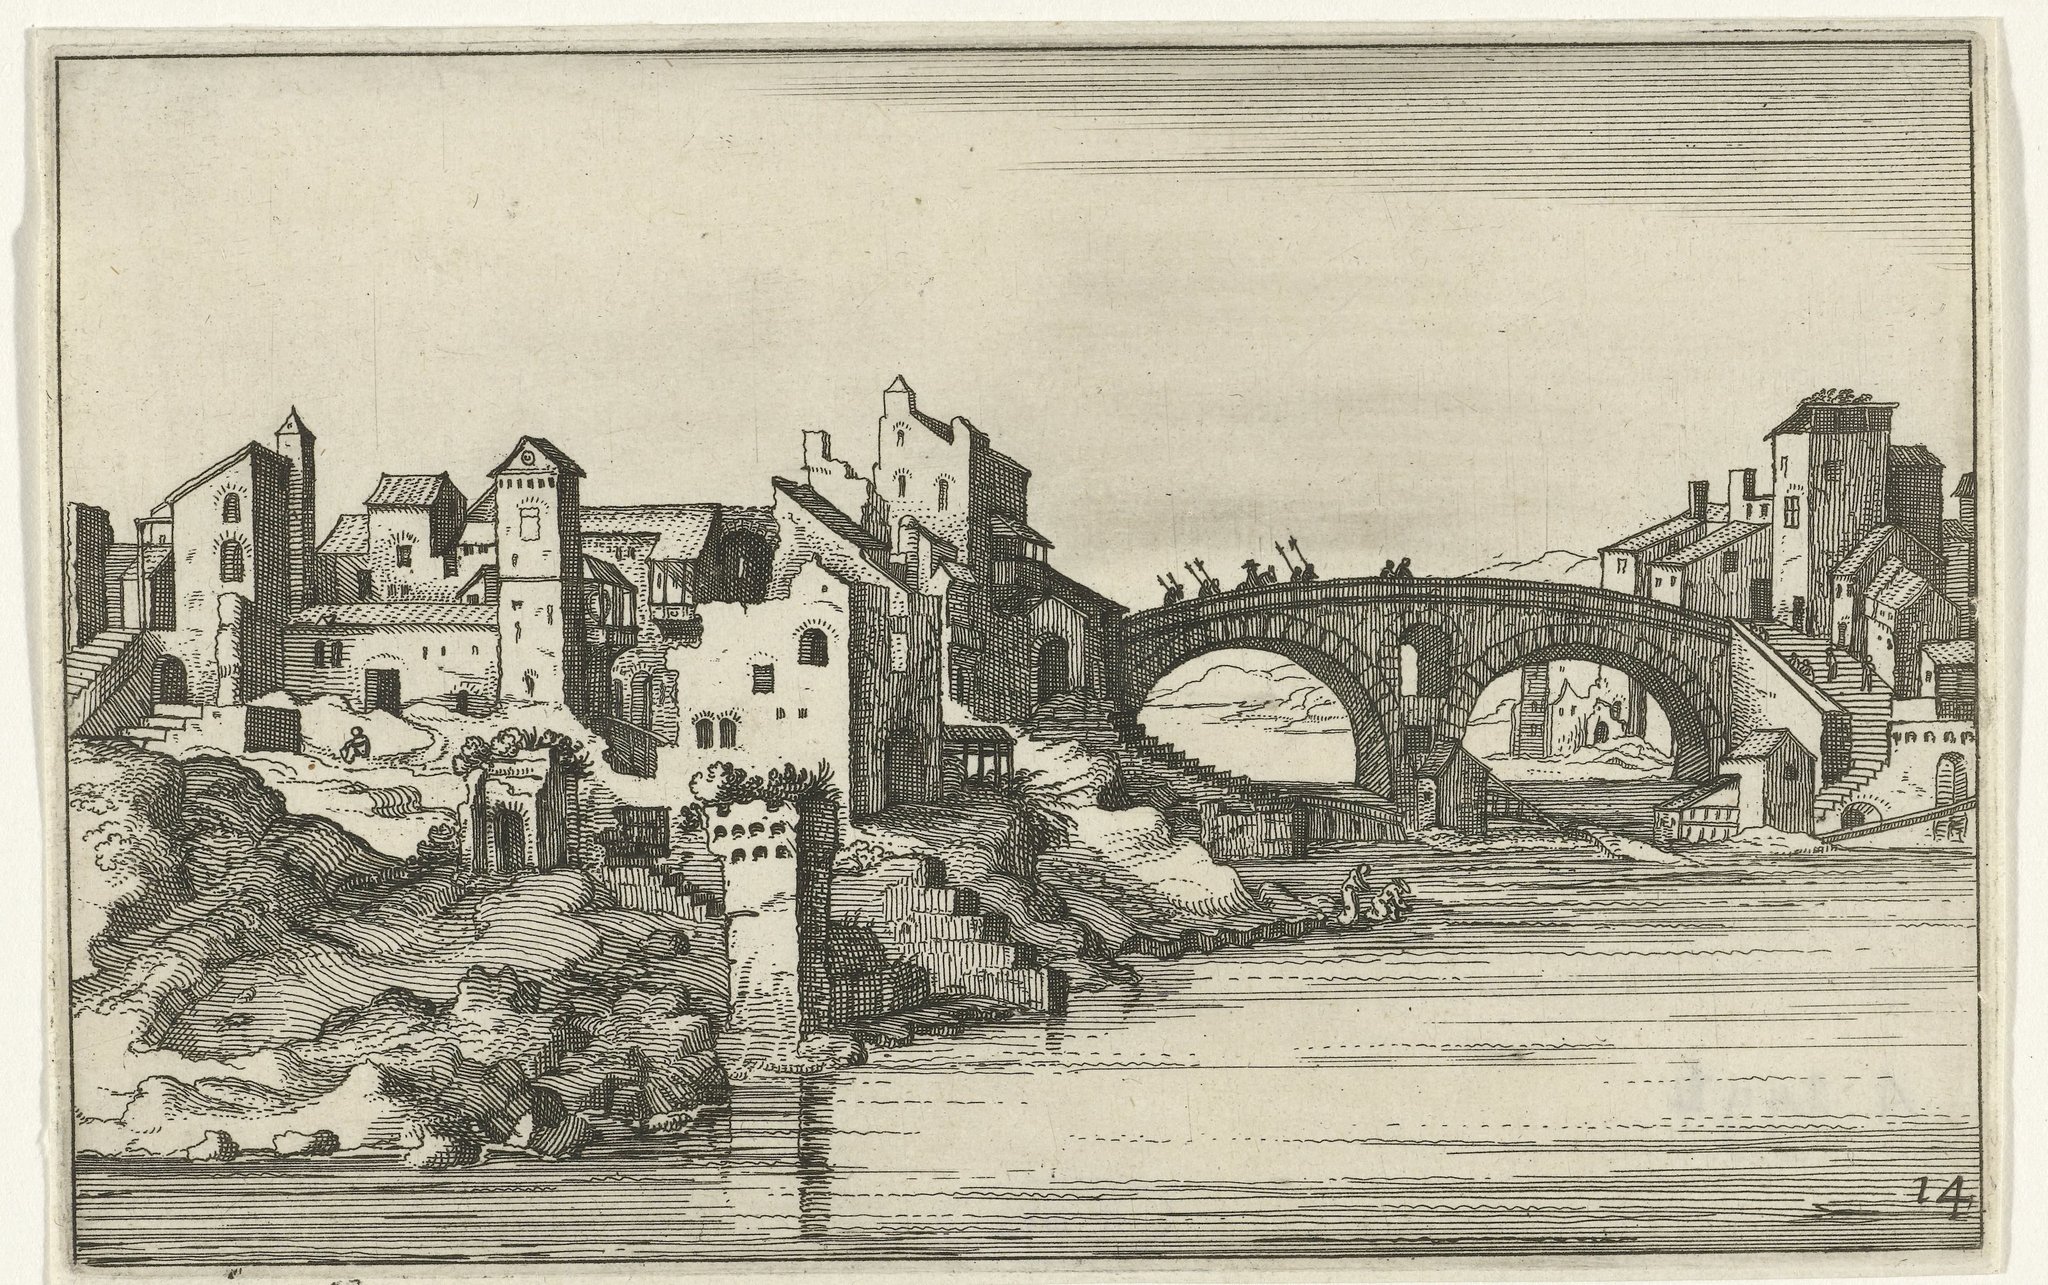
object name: print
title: Brug over de rivier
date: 1618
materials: paper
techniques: etching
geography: amsterdam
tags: ruin of a building ~ architecture, bridge in city across river, canal, etc.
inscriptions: collector's mark: Lugt 2228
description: Zicht op een rivier en een boogvormige brug. Op de linkeroever huizen en ruïnes. Enkele figuren lopen op de brug. Prent maakt deel uit van een serie Romeinse ruïnes en kustlandschappen naar een prentserie van Willem van Nieulandt.